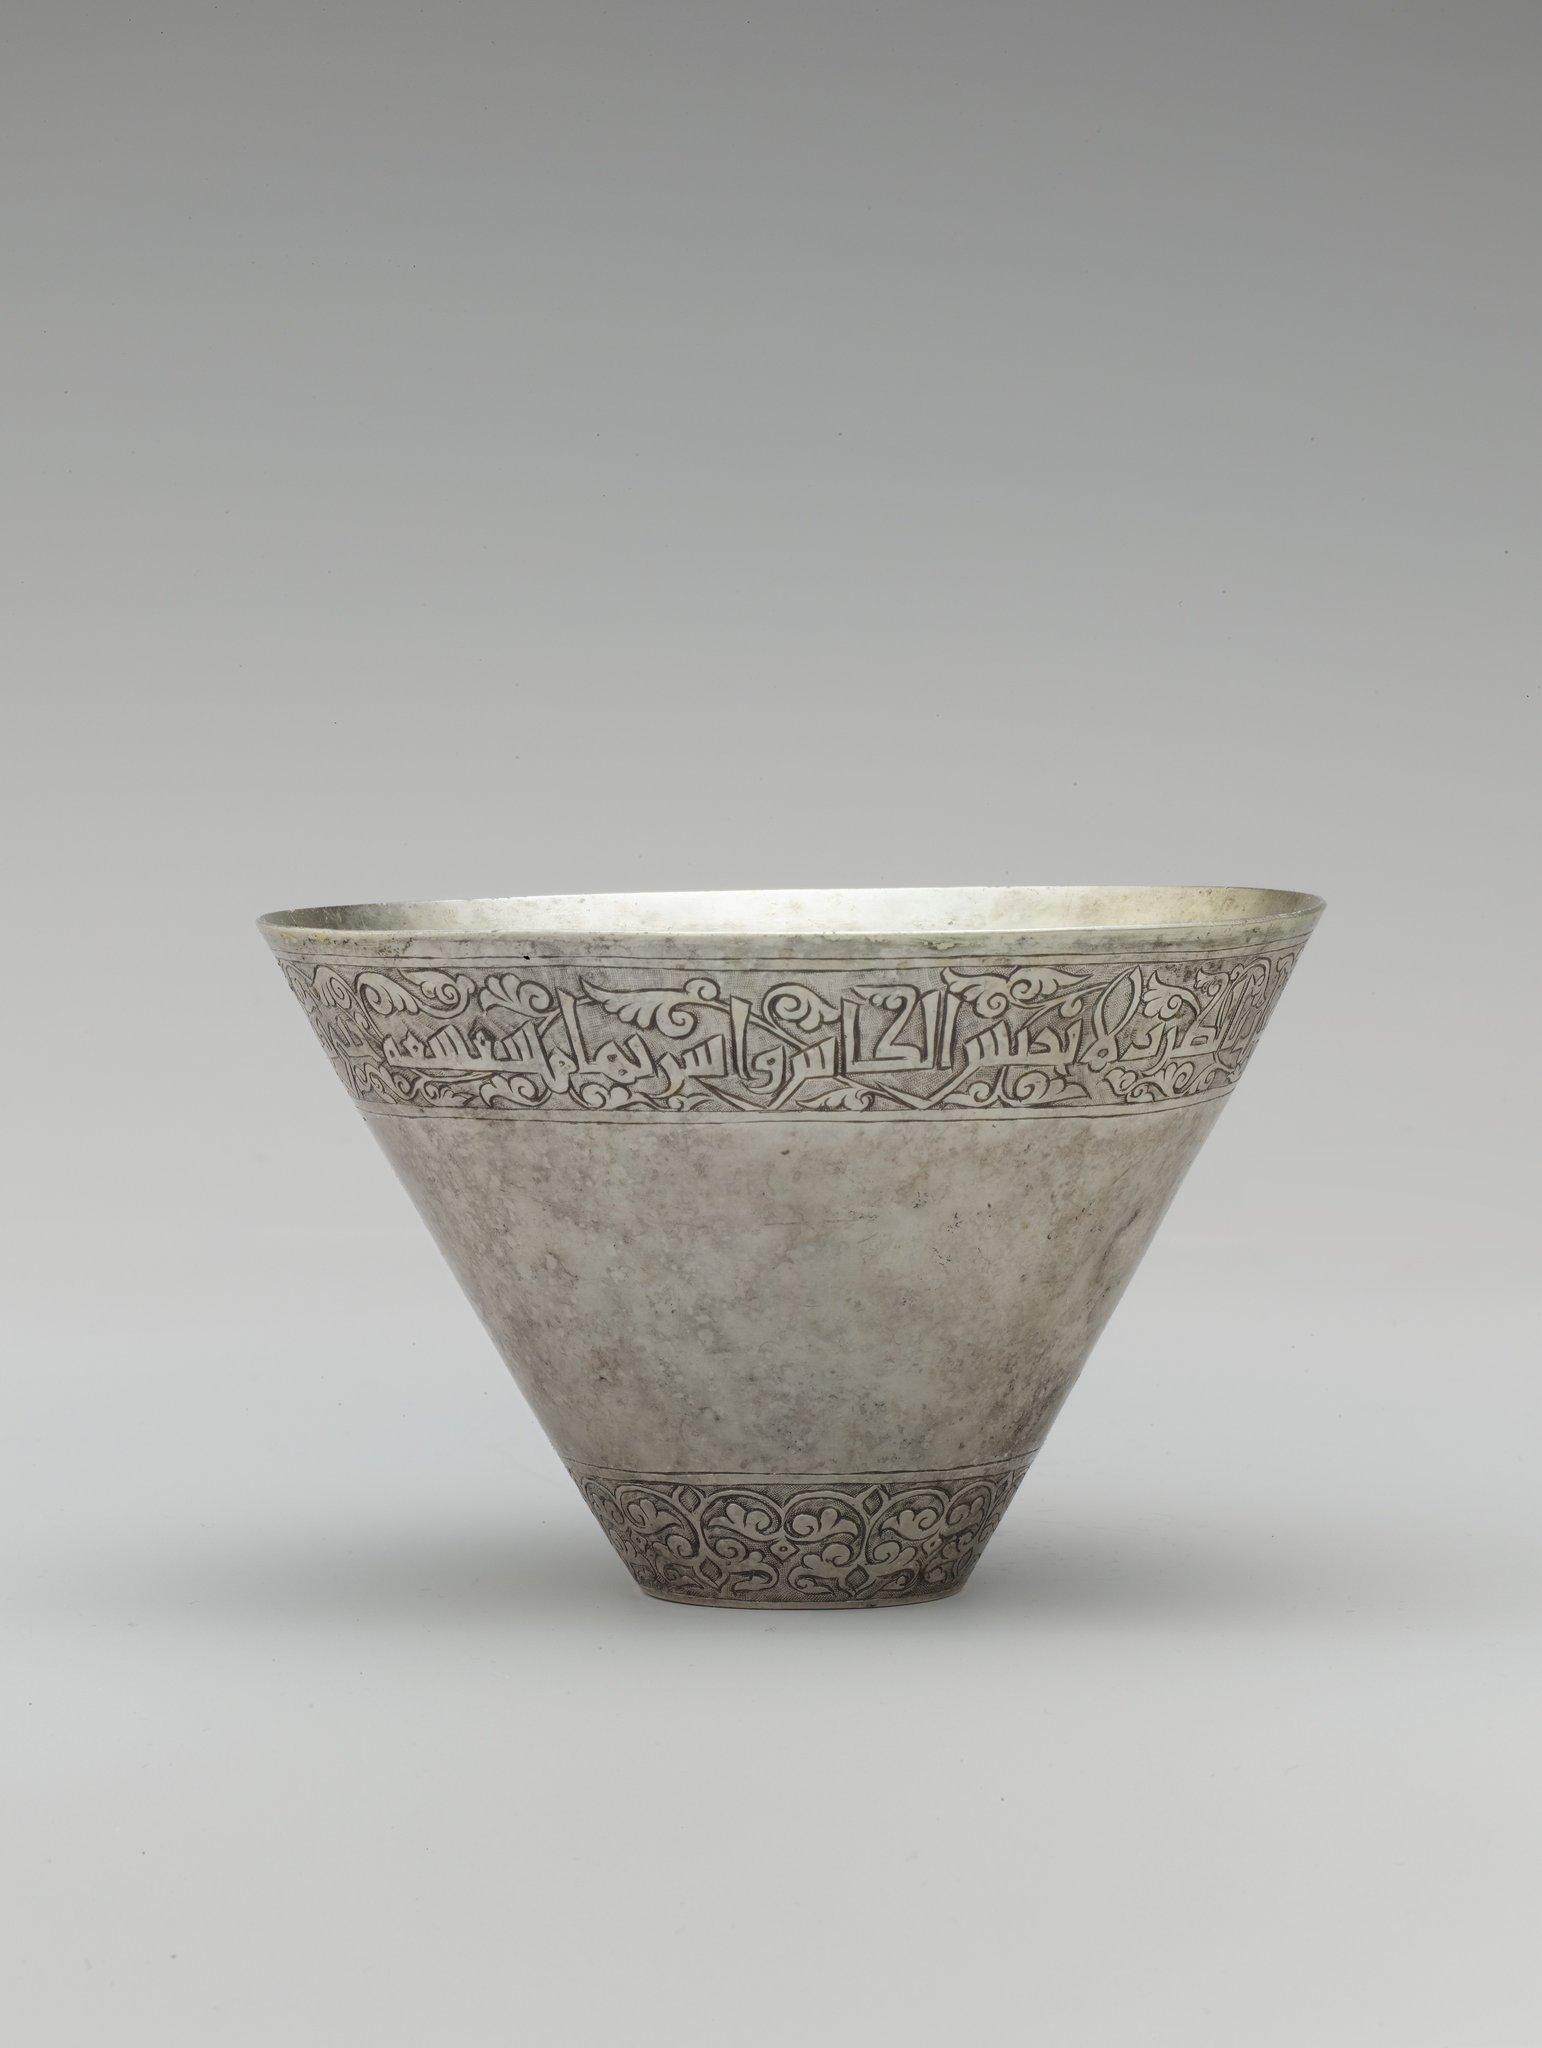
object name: cup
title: Cup with a Poem on Wine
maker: ibn sukkara al-hashimi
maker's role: poet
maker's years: 970-1020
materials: silver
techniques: chasing, gilding, hammering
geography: iran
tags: poetry,wine,arabic